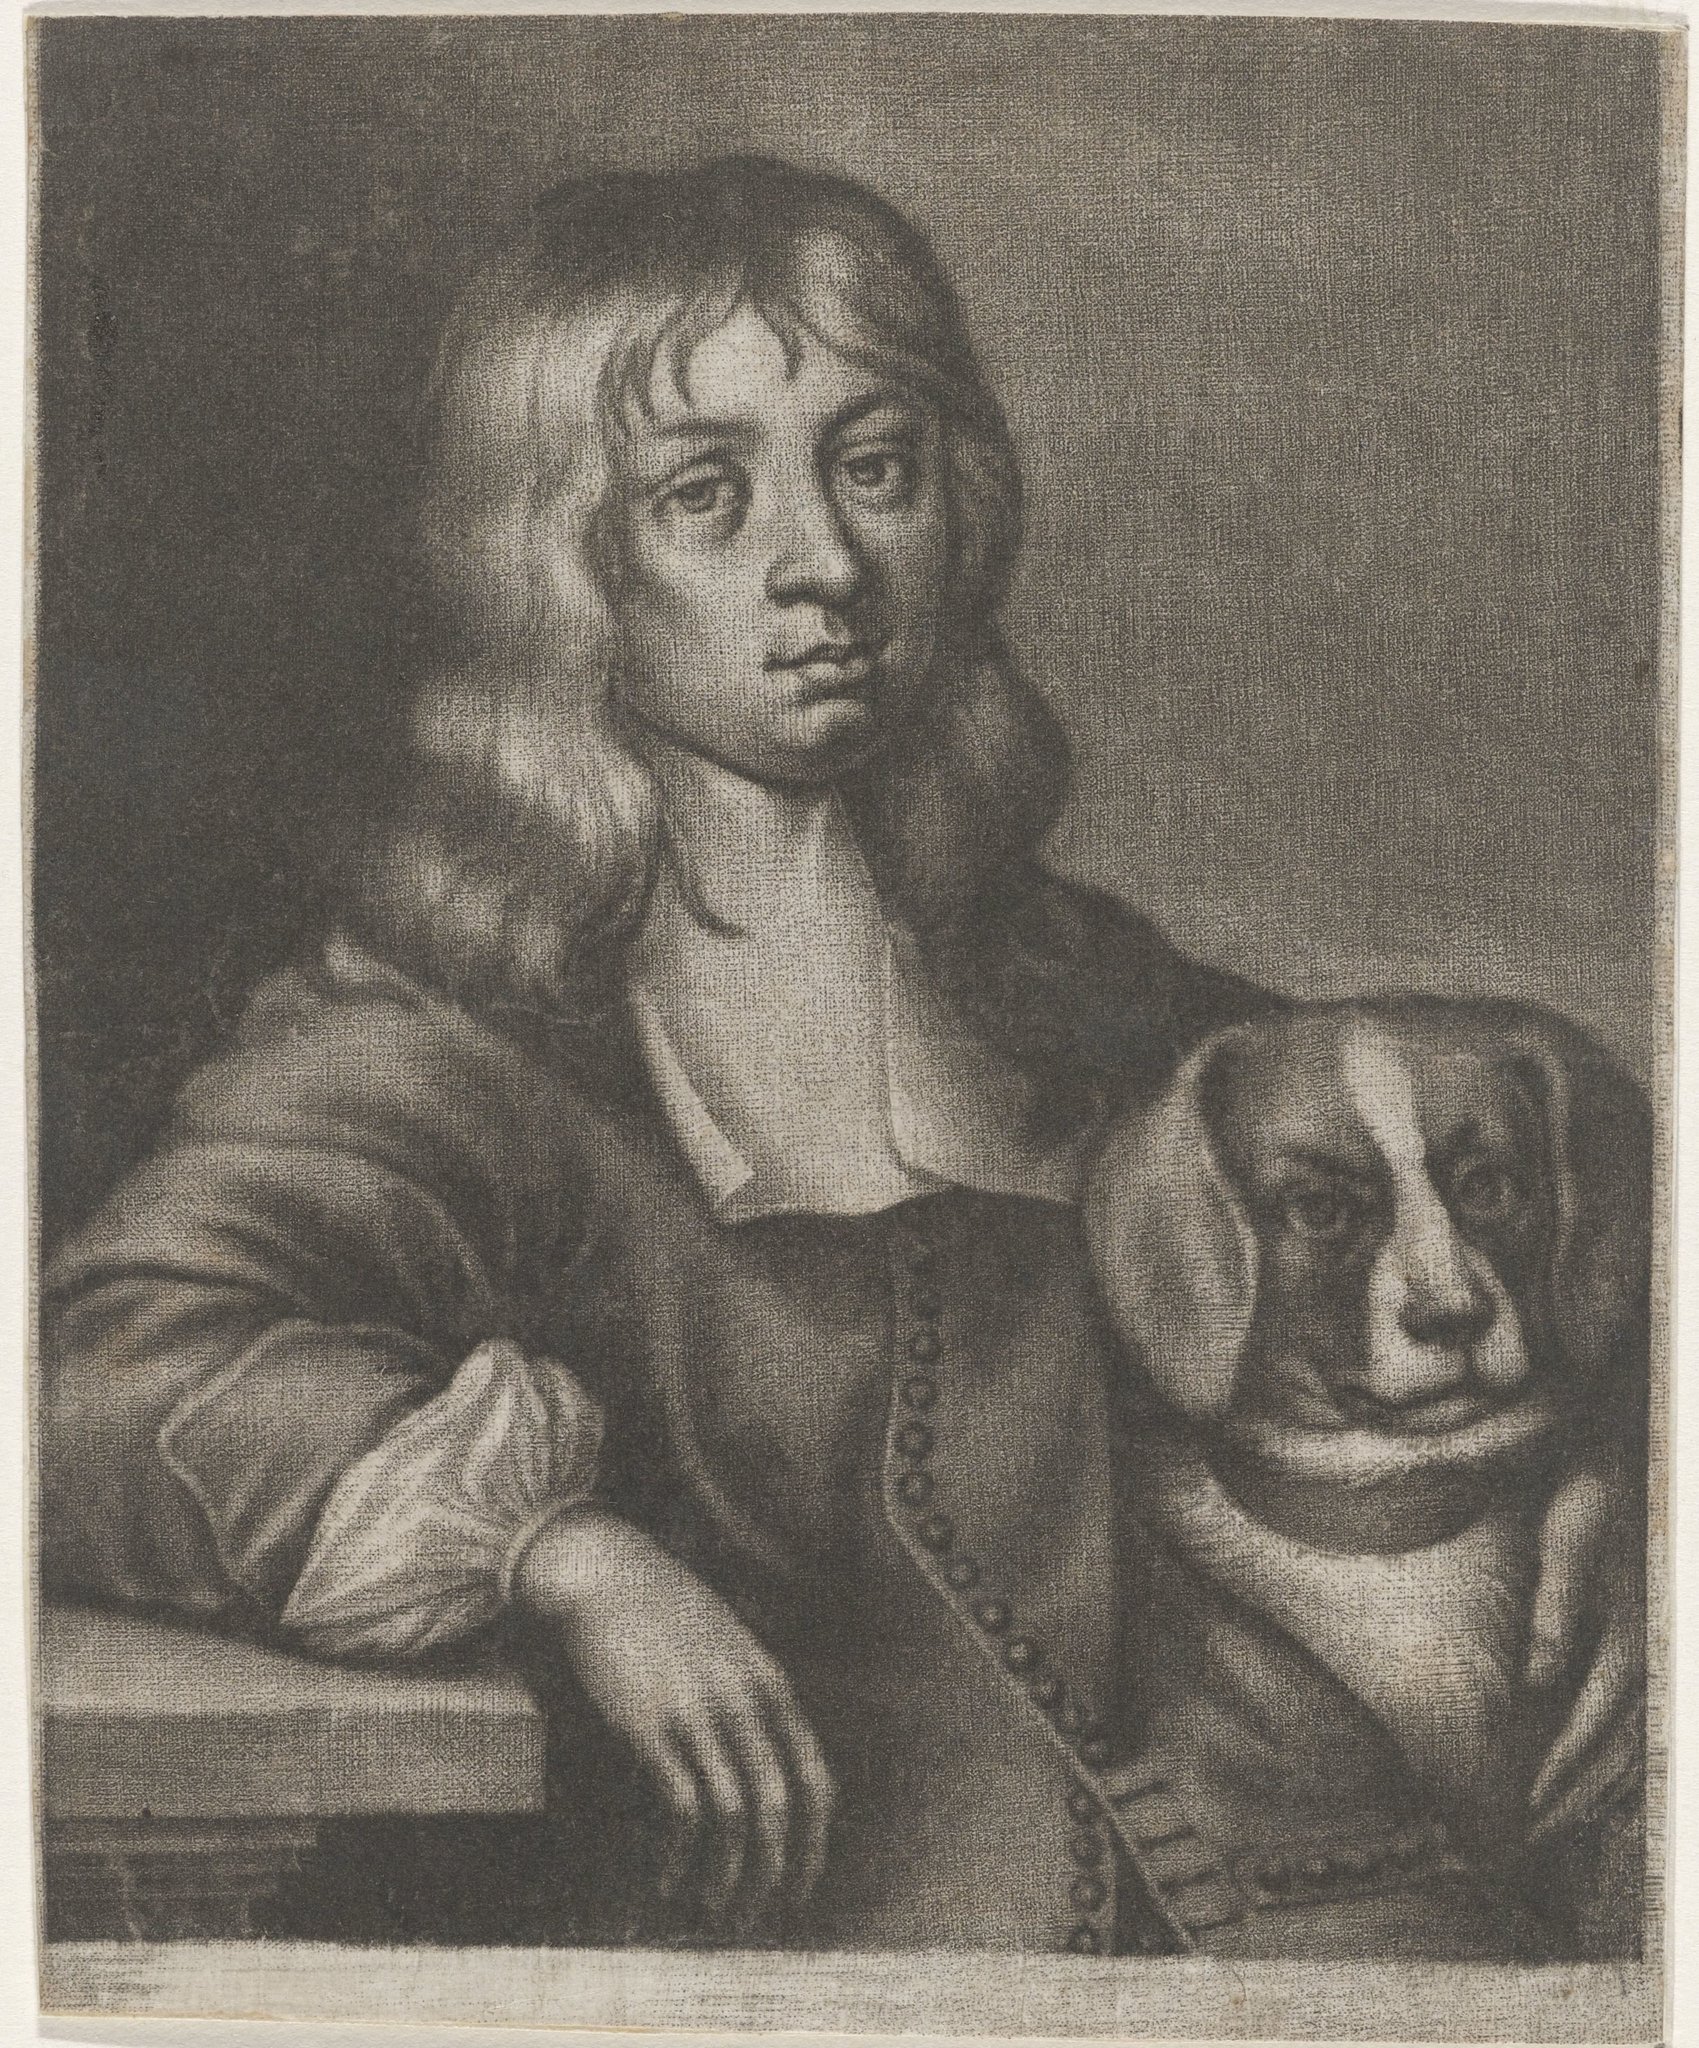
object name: print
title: Portret van Joh. Baltas. Schütz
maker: johann friedrich leonard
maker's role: print maker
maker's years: 1633-1680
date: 1672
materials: paper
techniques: mezzotint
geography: vienna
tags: dog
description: De jonge Joh. Baltas. Schütz leunt met zijn arm op een tafel en houdt onder de andere arm een hond.